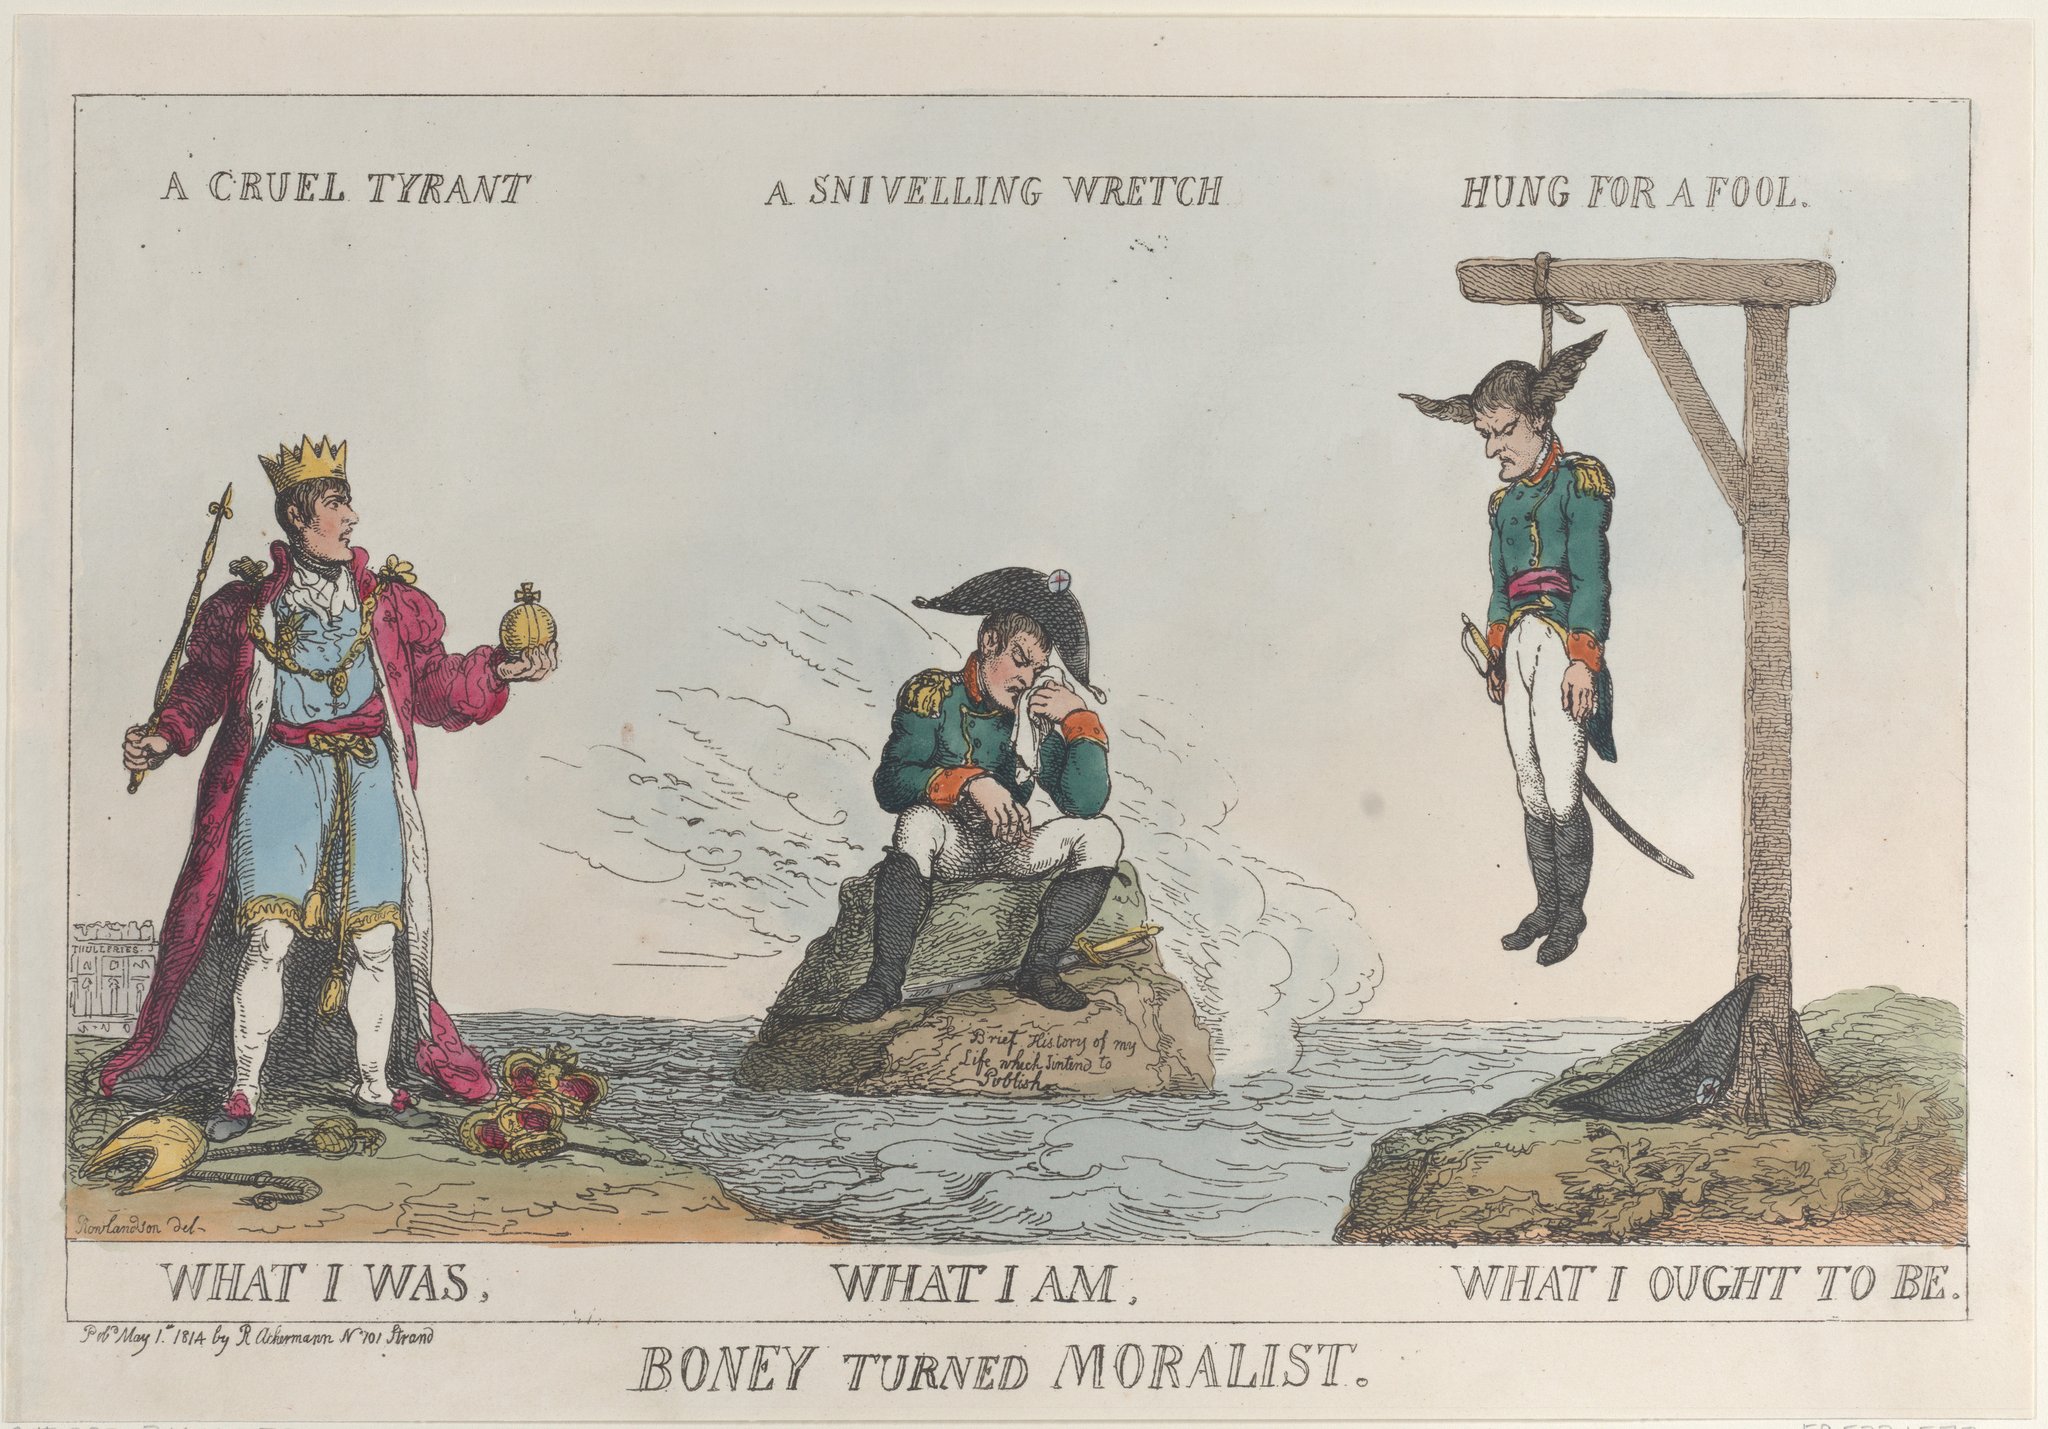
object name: print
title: Boney Turned Moralist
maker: thomas rowlandson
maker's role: artist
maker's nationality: british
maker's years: 1757-1827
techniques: etching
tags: satire,napoleon i,politics